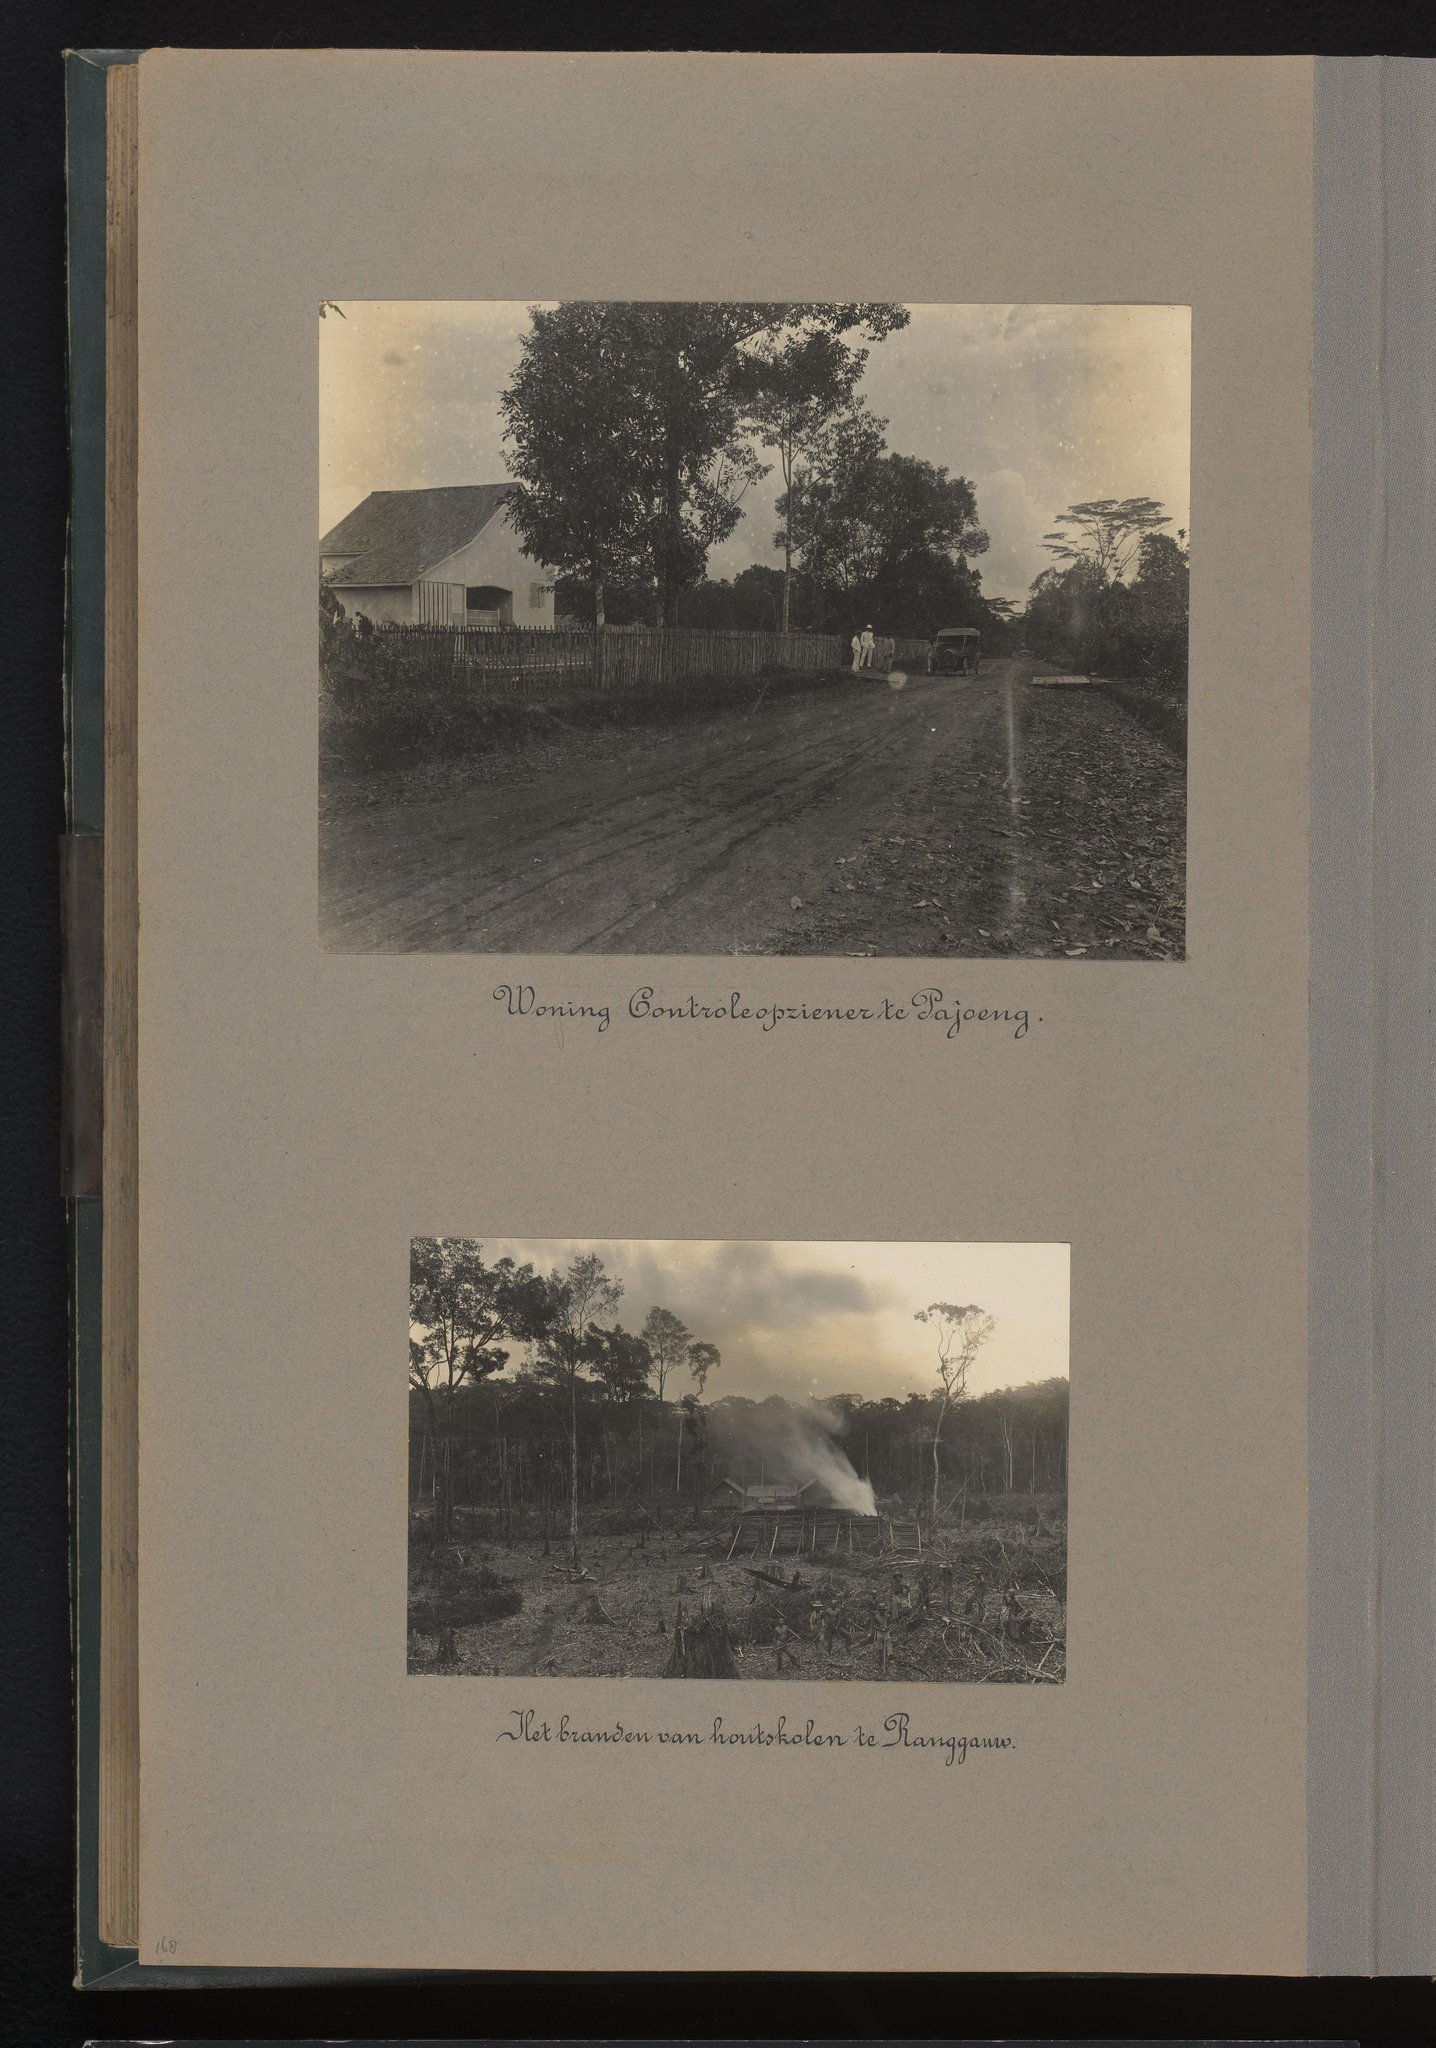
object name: album leaf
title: Woning te Pajoeng en branden van houtskool te Ranggauw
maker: Anonymous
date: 1914-1919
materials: cardboard, photographic support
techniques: gelatin silver print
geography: bangka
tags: robert julius boers, colonial system, opencast mine; strip mining, charcoal burning, charcoal burner, wood collier, villa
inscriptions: inscription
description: Albumblad met 2 foto's van een woning te Pajoeng en branden van houtskool te Ranggauw, bij de mijnbouwonderneming te Koba. Onderdeel van het fotoalbum aangeboden aan Robert Julius Boers bij zijn vertrek naar Nederland in 1919 door het personeel van de Banka-tinwinning.